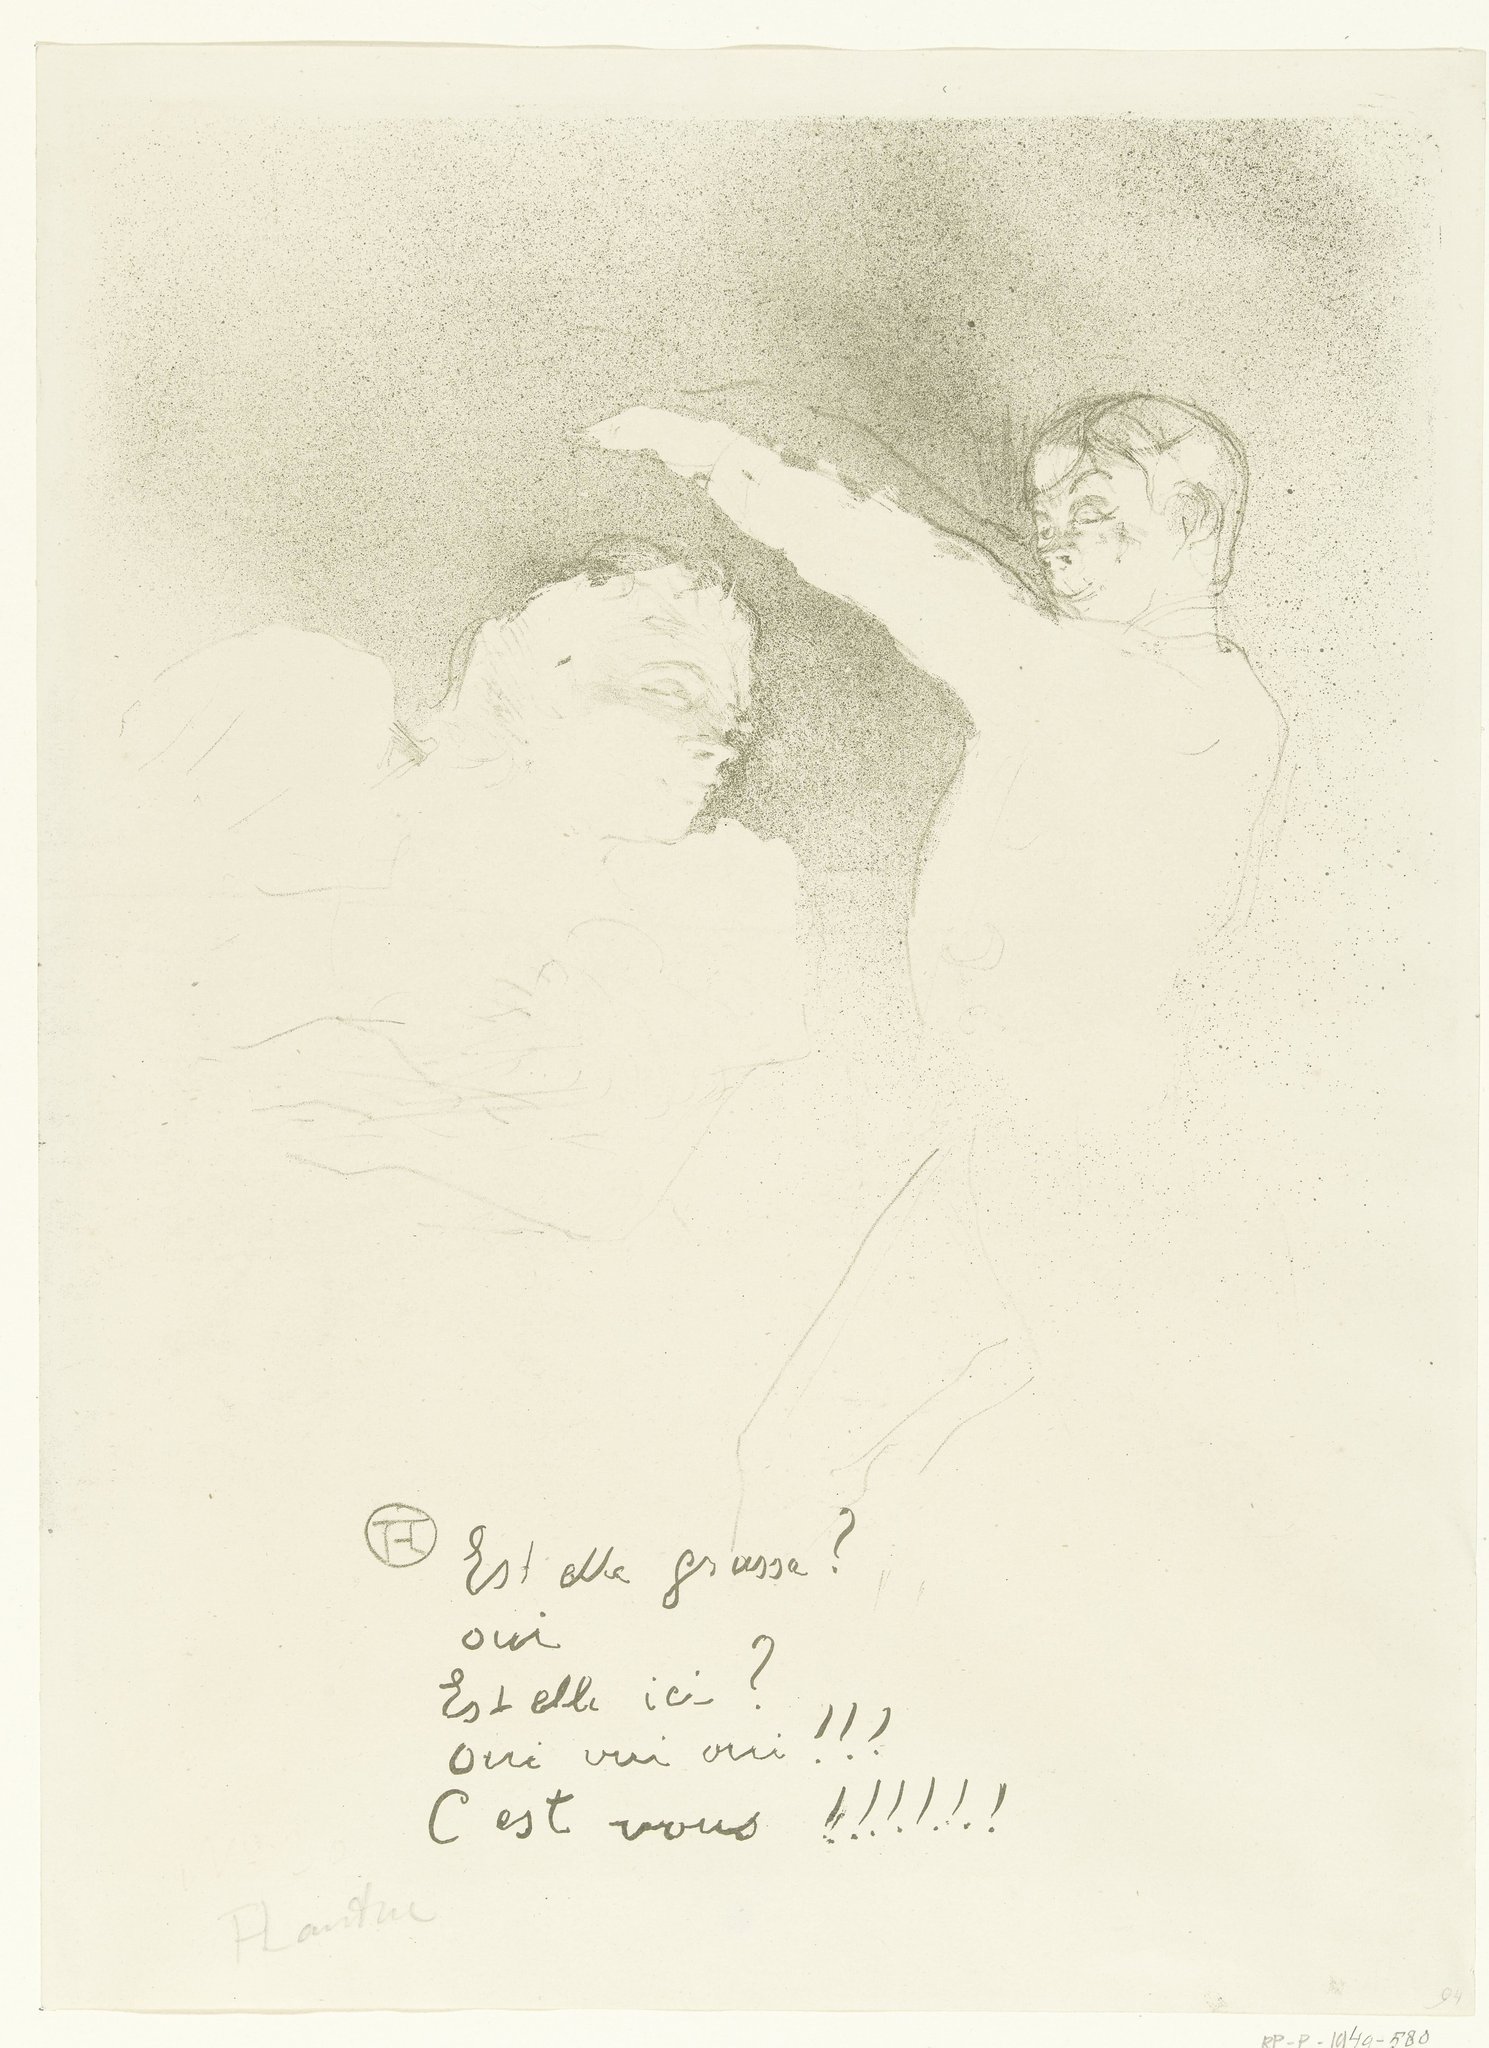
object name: print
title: Aux Variété's Mademoiselle Lender et Brasseur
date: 1893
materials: paper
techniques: printing, lithograph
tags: singer without accompaniment, vaudeville, variety-show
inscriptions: collector's mark: Lugt 2760, collector's mark: Lugt 2228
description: Deze lithografie behoort tot de genummerde oplage van honderd exemplaren maar het nummer, geschreven in potlood boven het signatuur, lijkt gewist en is moeilijk leesbaar (No 30). De prent werd gepubliceerd in het tijdschrift L'Escarmouche, 19 november 1893 als reproductie. De honder in oplage gedrukte litho's werden los verkocht om het nieuwe tijdschrift te financieren.